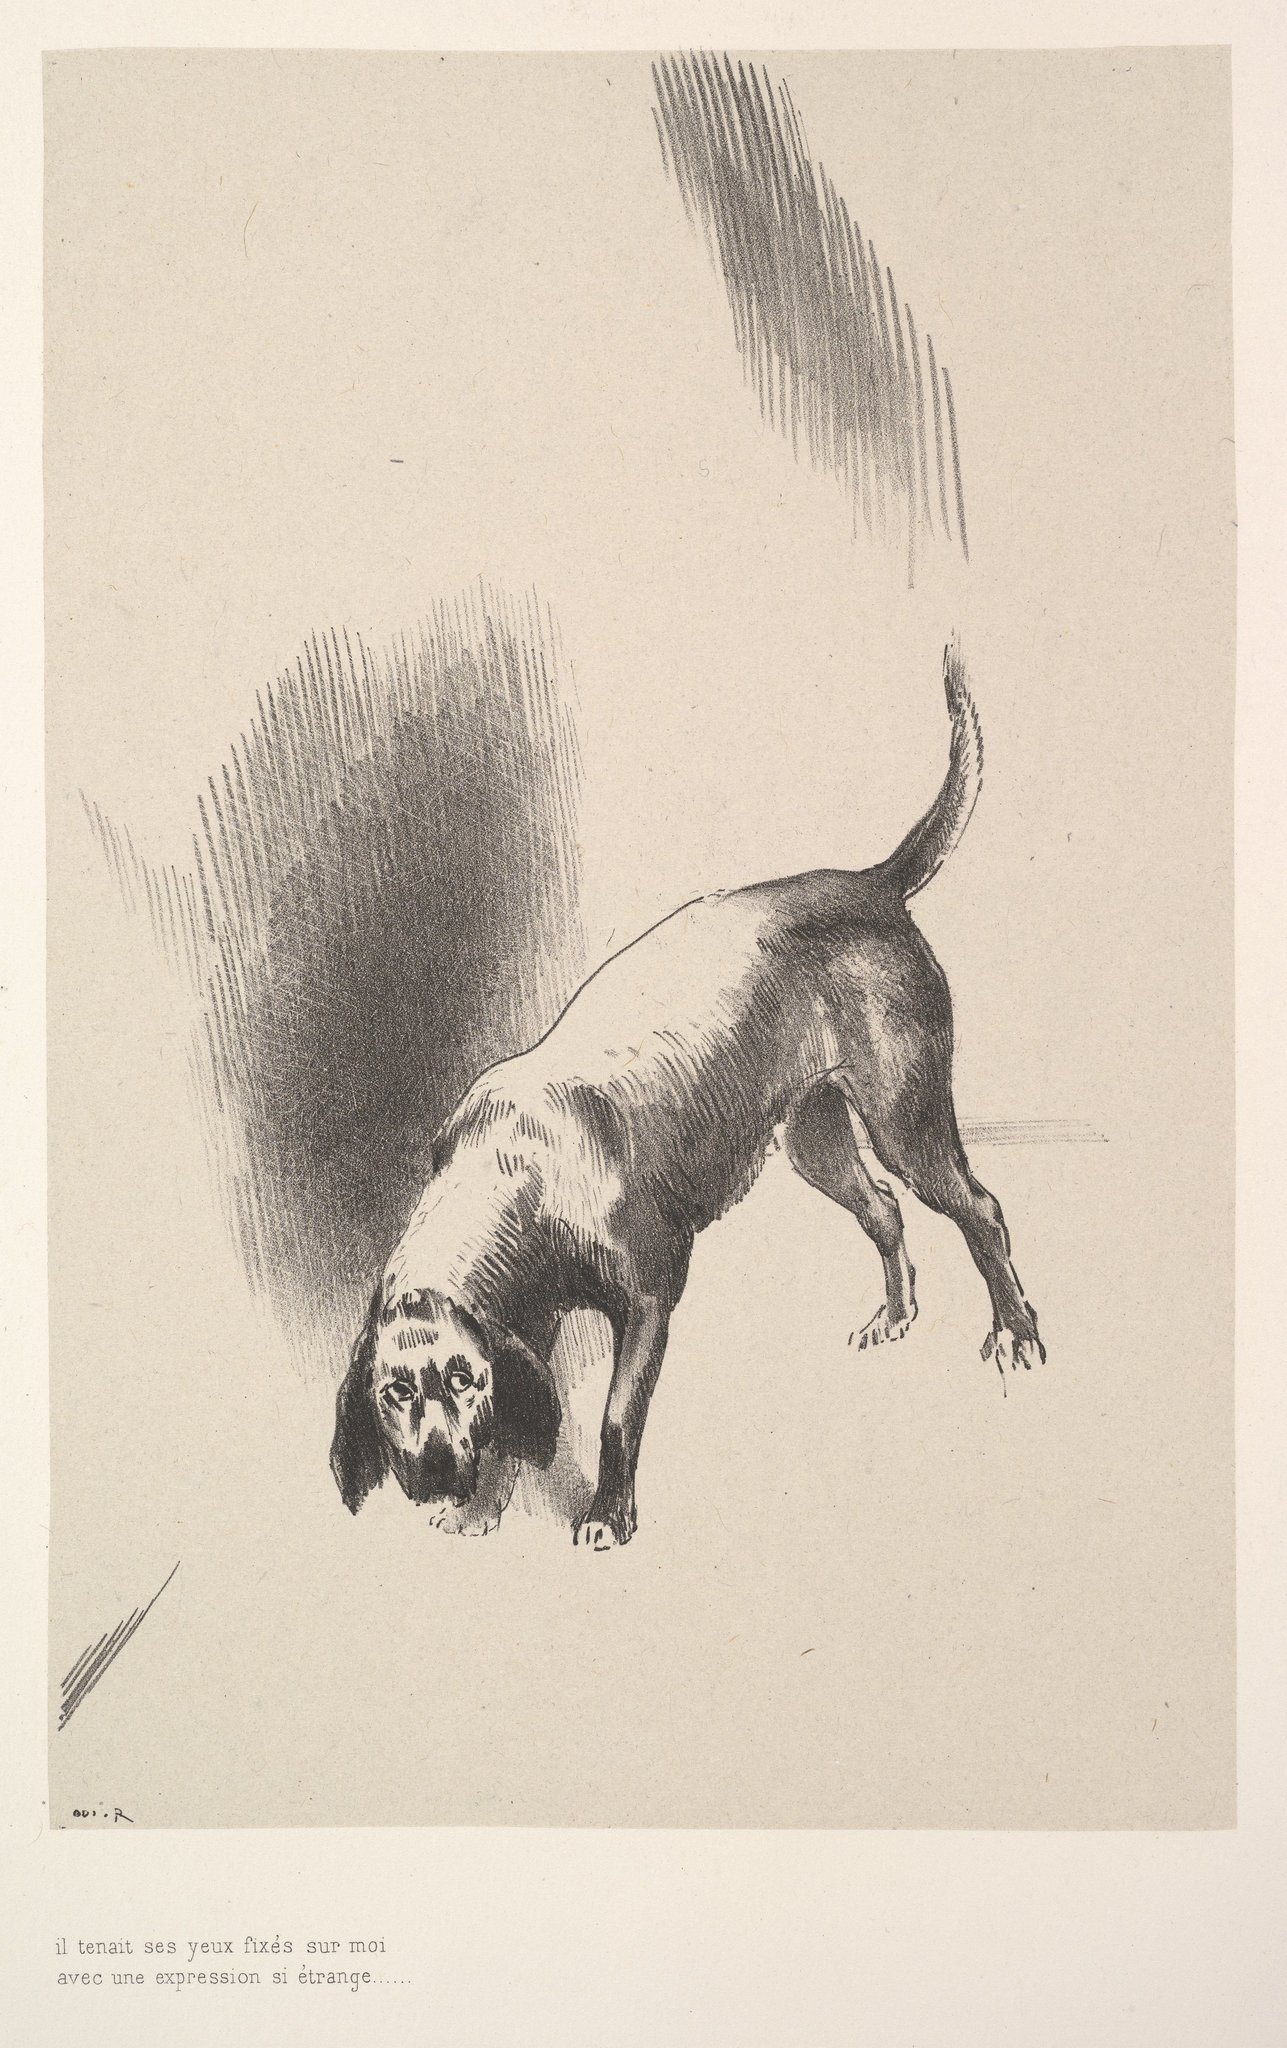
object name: print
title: He fixed his eyes on me with an expression that was so strange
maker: odilon redon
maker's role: artist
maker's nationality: french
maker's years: 1840-1916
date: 1896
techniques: lithograph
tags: dogs